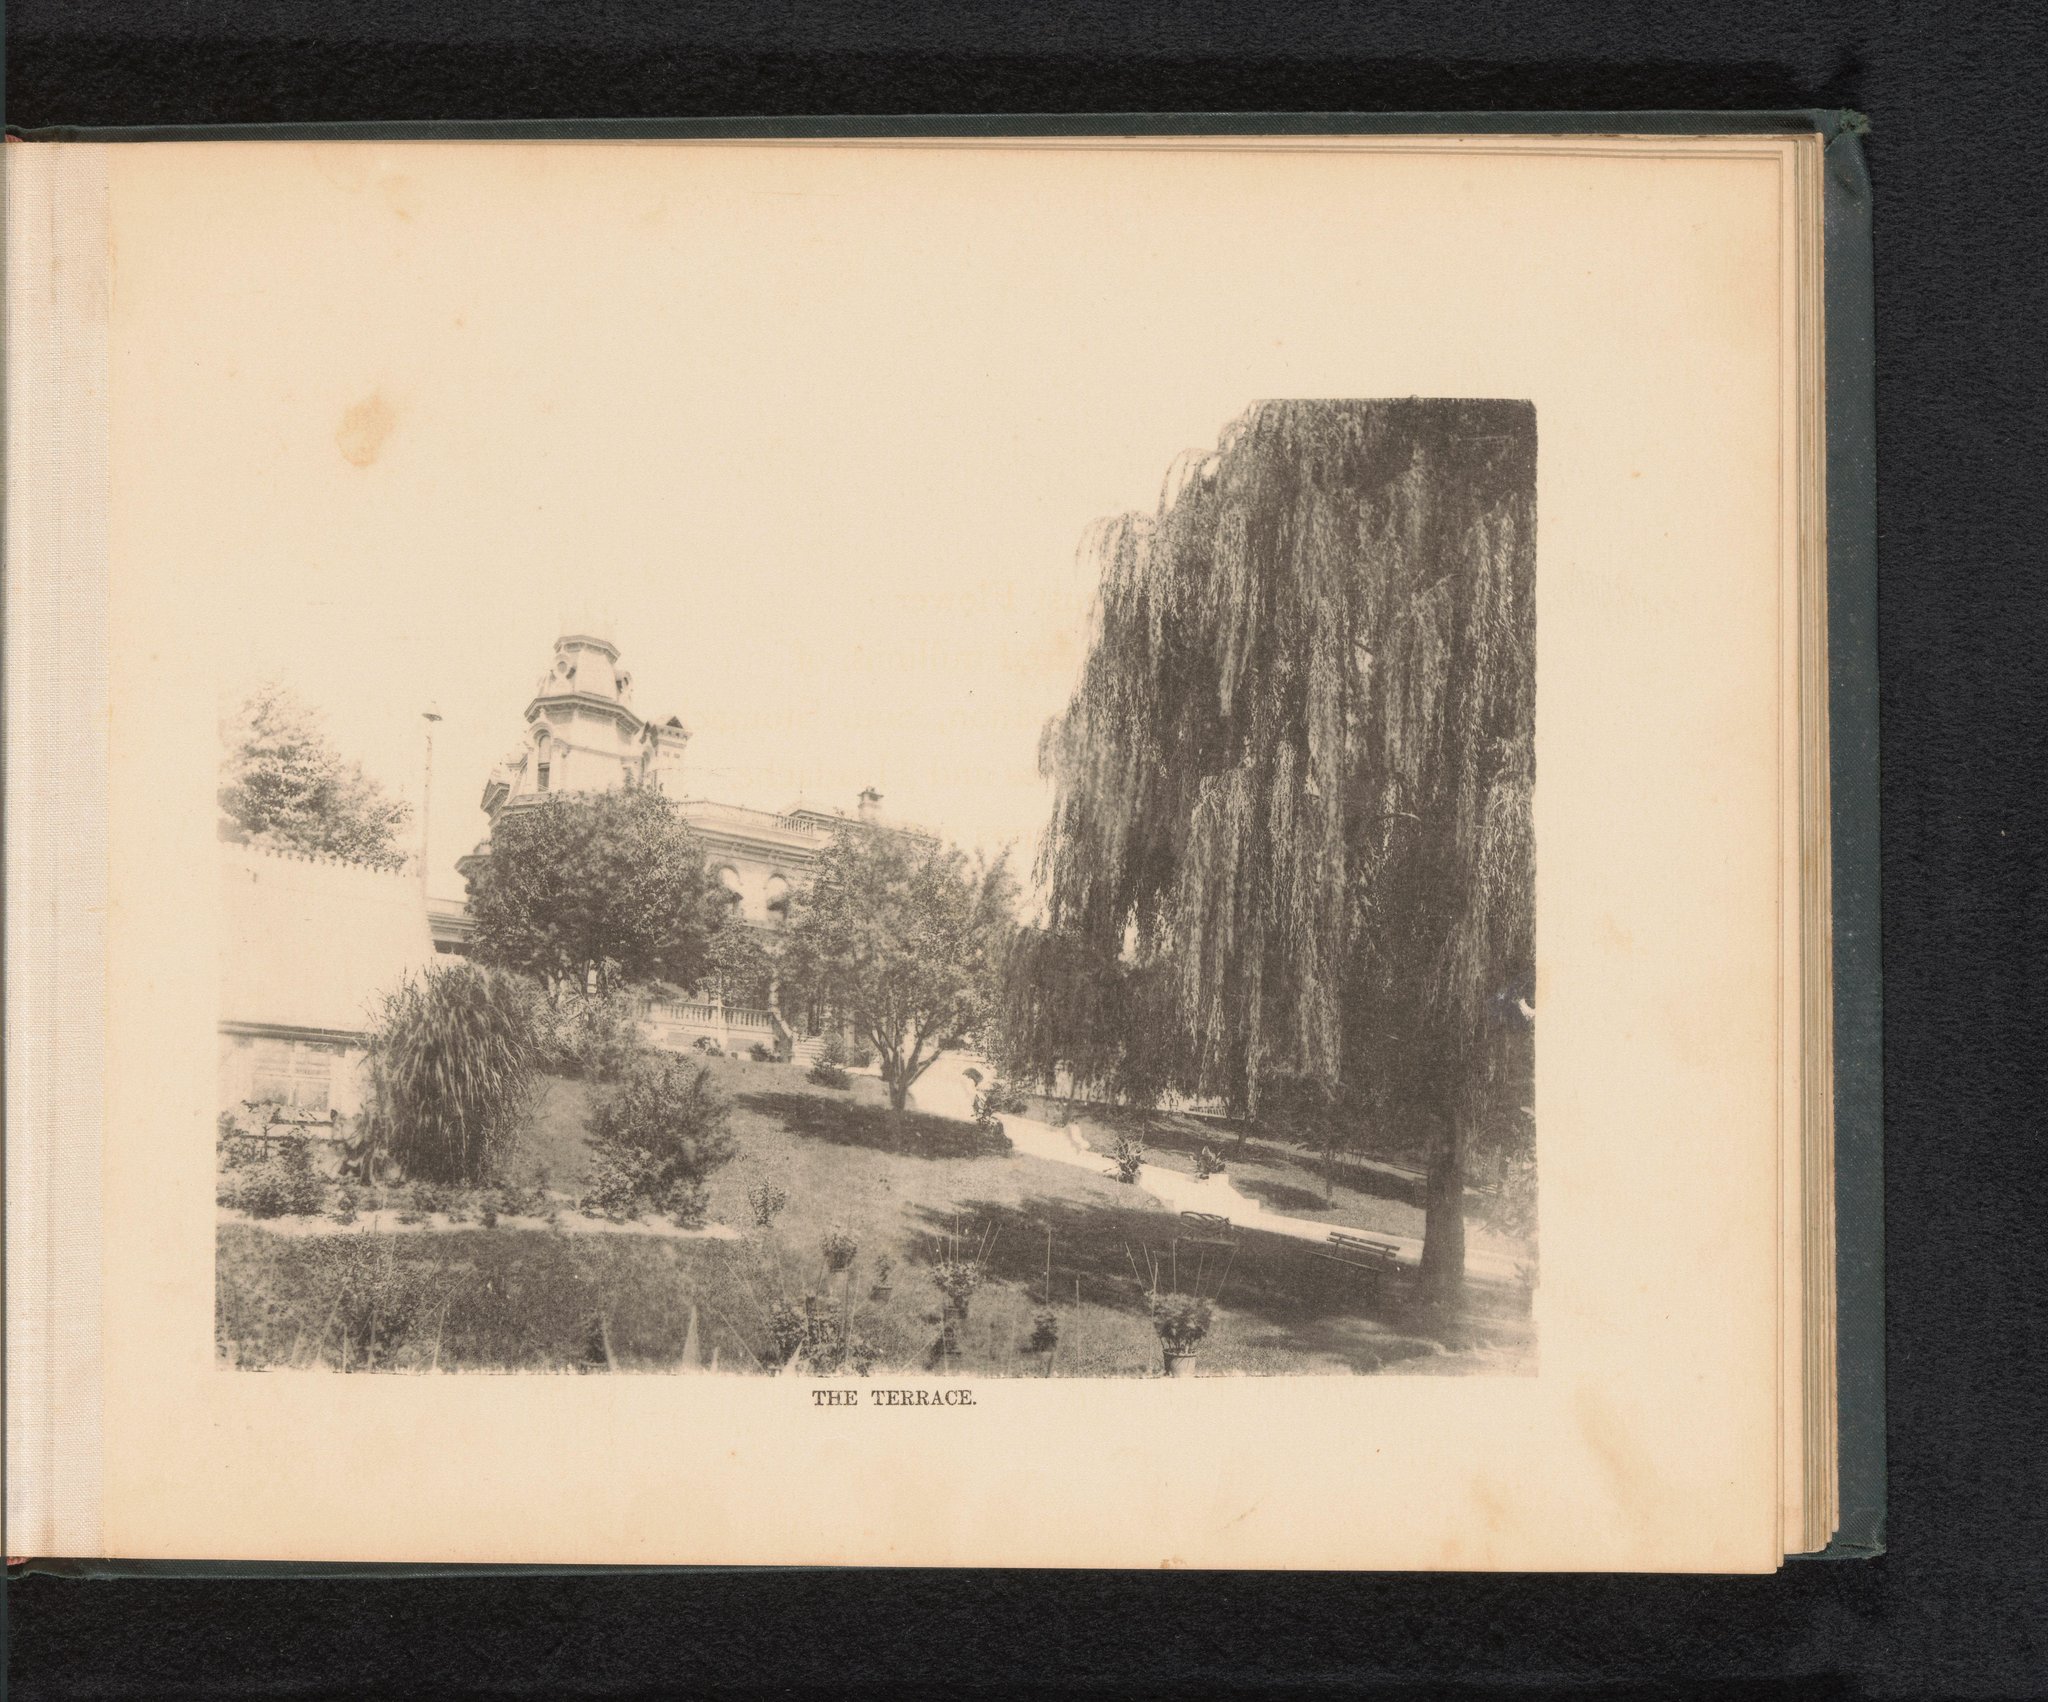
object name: page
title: The Terrace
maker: Anonymous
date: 1879-1889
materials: paper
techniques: photograph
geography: woodbury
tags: villa, terrace